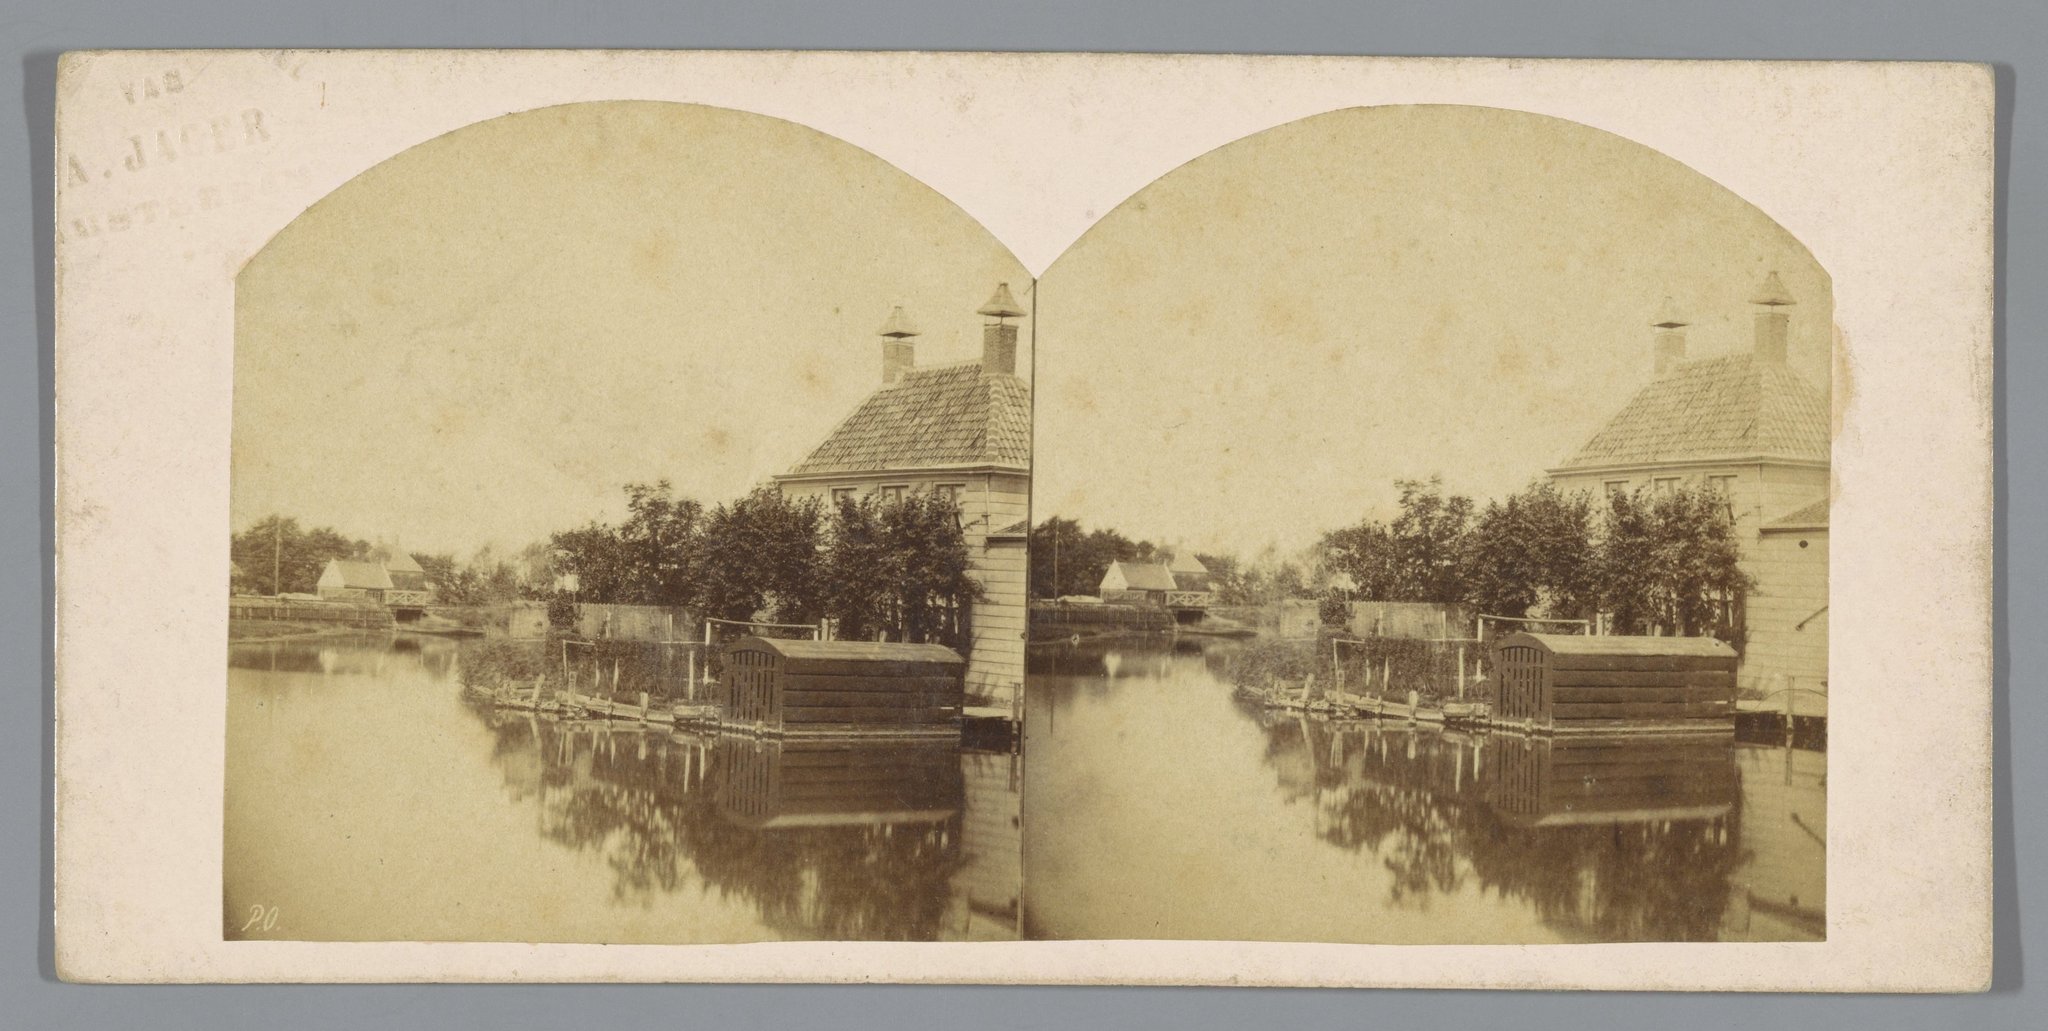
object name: stereograph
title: Het dorp Sloterdijk, van de Haarlemmerweg af gezien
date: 1859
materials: cardboard, paper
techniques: albumen print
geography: sloterdijk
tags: canals, waters (in village), sloterdijk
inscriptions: number: ‘2’, inscription: ‘Gephotographiëerd in Julij 1859./ Uitgegeven door A. Jager, Water 110, te Amsterdam.’, inscription: ‘Van/ A. Jager/ Amsterdam’, inscription: ‘foto Pieter Oosterhuis’, initials: ‘P.O.’